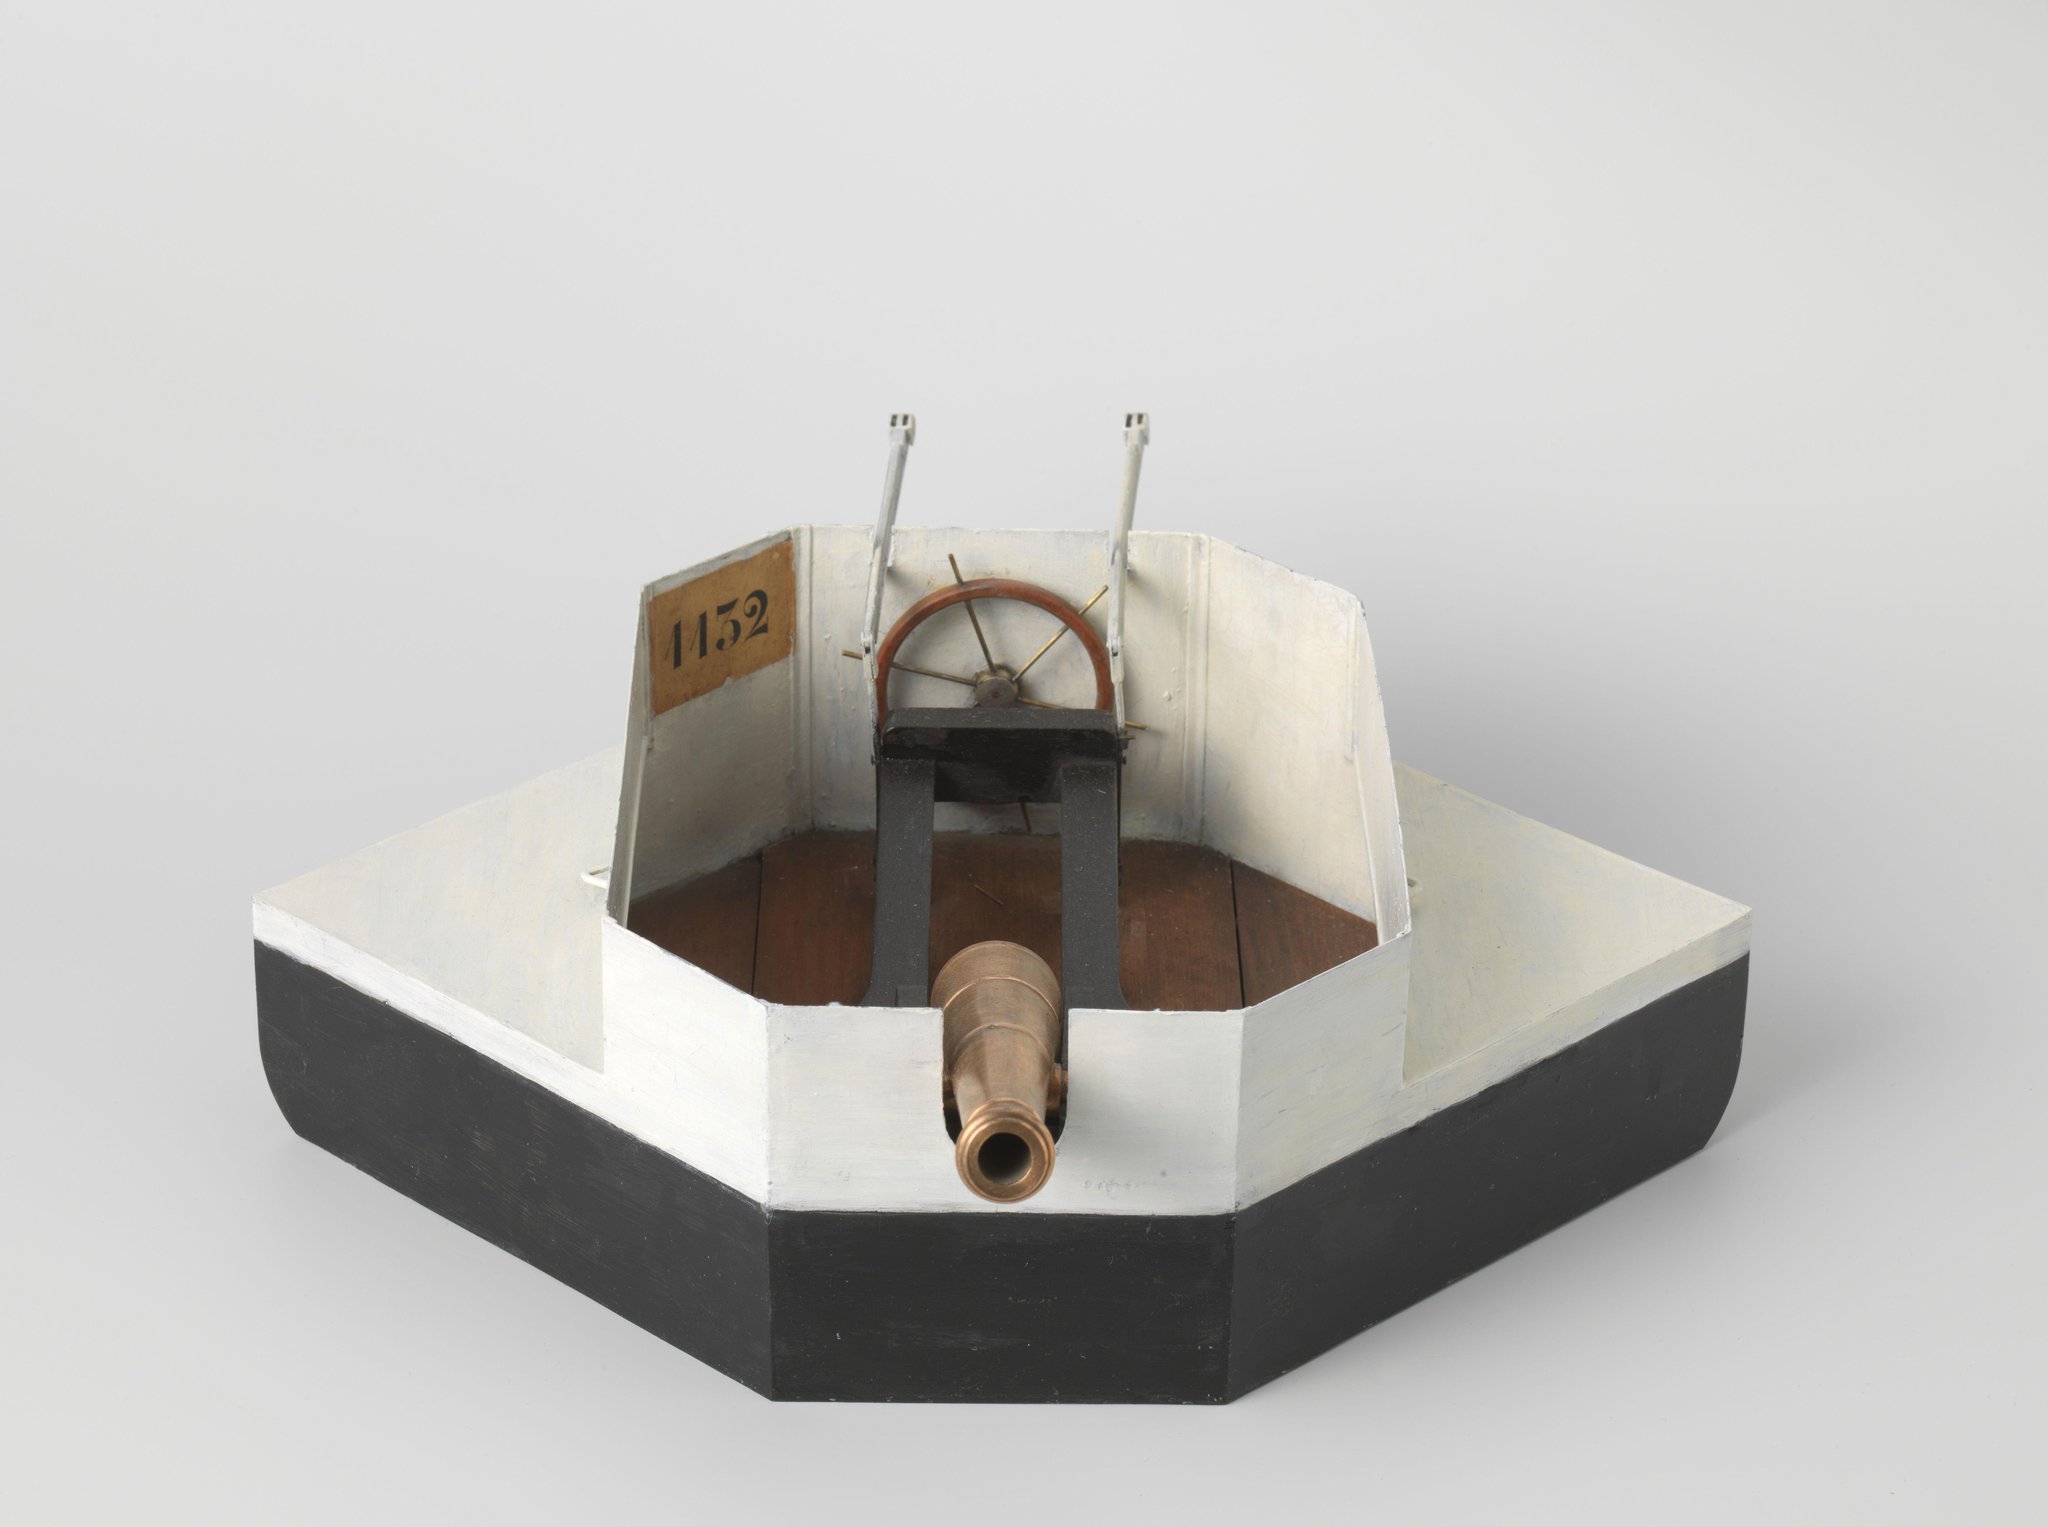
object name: demonstration model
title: Model of a Floating Battery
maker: Anonymous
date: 1860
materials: brass, wood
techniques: polychromy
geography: netherlands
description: Gepolychromeerd messing model van een vlotbatterij, vermoedelijk incompleet. Het drijvende lichaam is een zeskantig vlot, zwart wit geverfd, met een rechthoekige opening bovenin waarin een kanon op schuifslede staat; deze opening is omgeven door een rechtopstaande rand. Achterin is een groot wiel aangebracht, dat een schijf aan de buitenkant bedient, waarover een stuurketting dient te lopen: deze ketting ligt vast in het water en door aan het wiel te draaien beweegt het vlot heen en weer. Een stel davits, bevestigd aan de achterkant van de slede, steekt achter buitenboord. Schaal 1:20 (volgens Obreen).